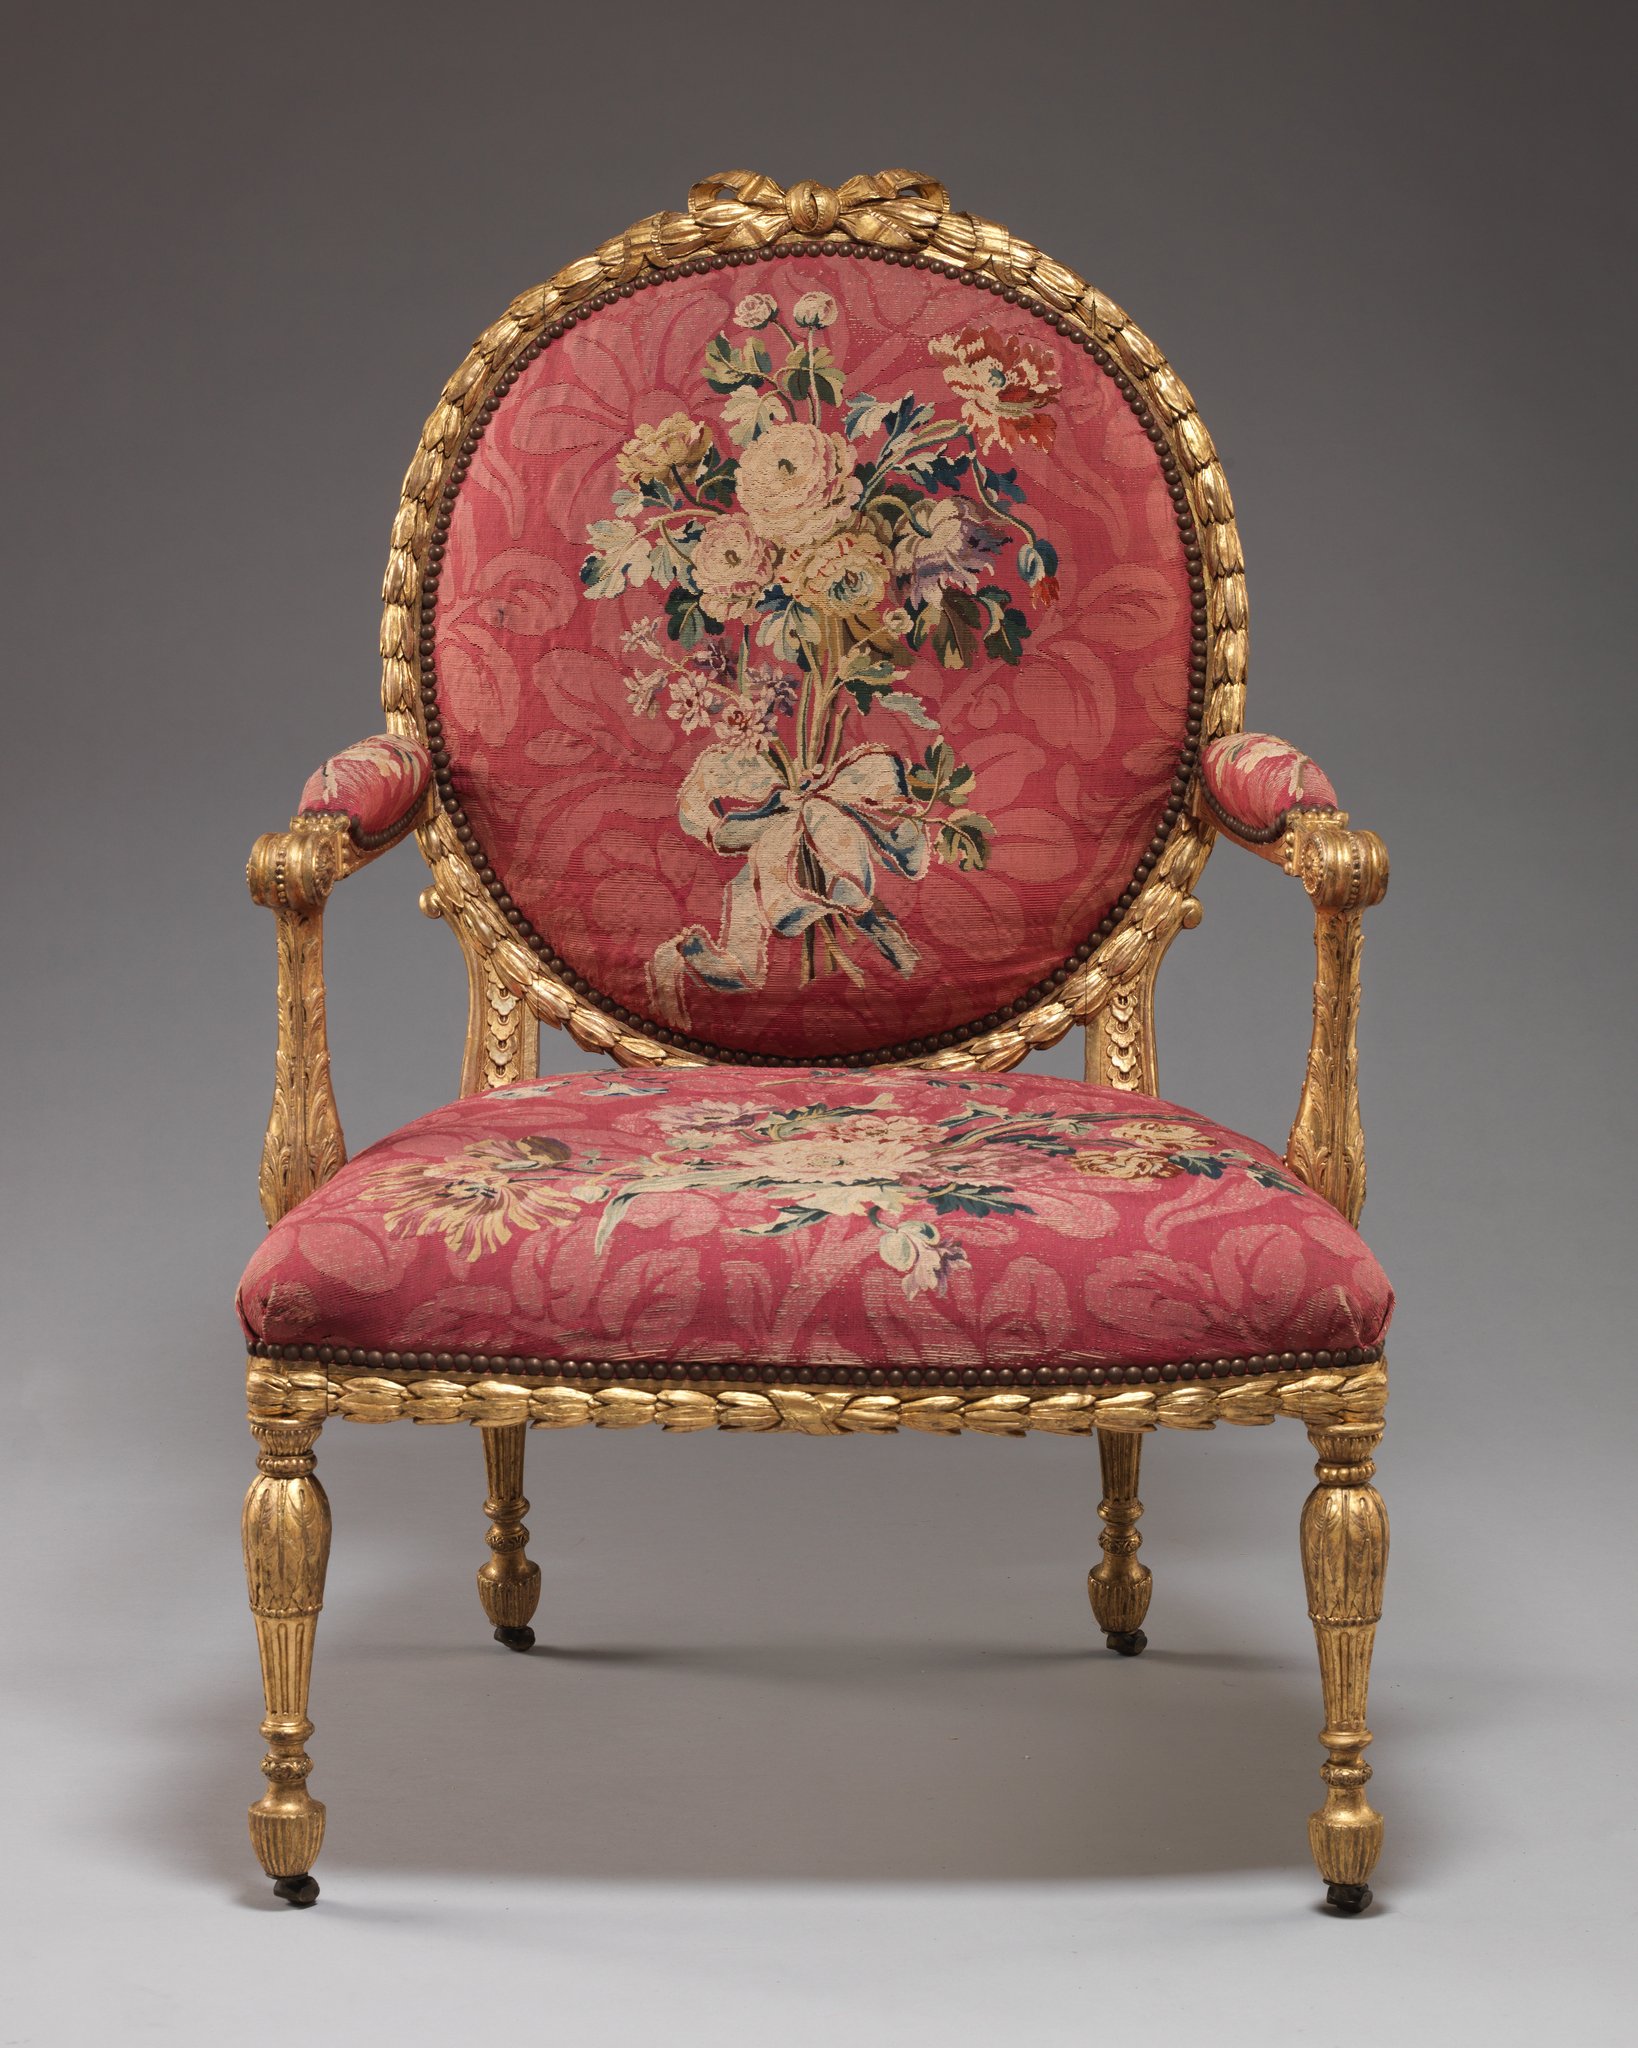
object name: armchair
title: Armchair (one of a set of six)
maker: john mayhew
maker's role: maker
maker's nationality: british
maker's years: 1736-1811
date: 1769-1771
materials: wood, silk, wool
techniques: gilding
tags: flowers